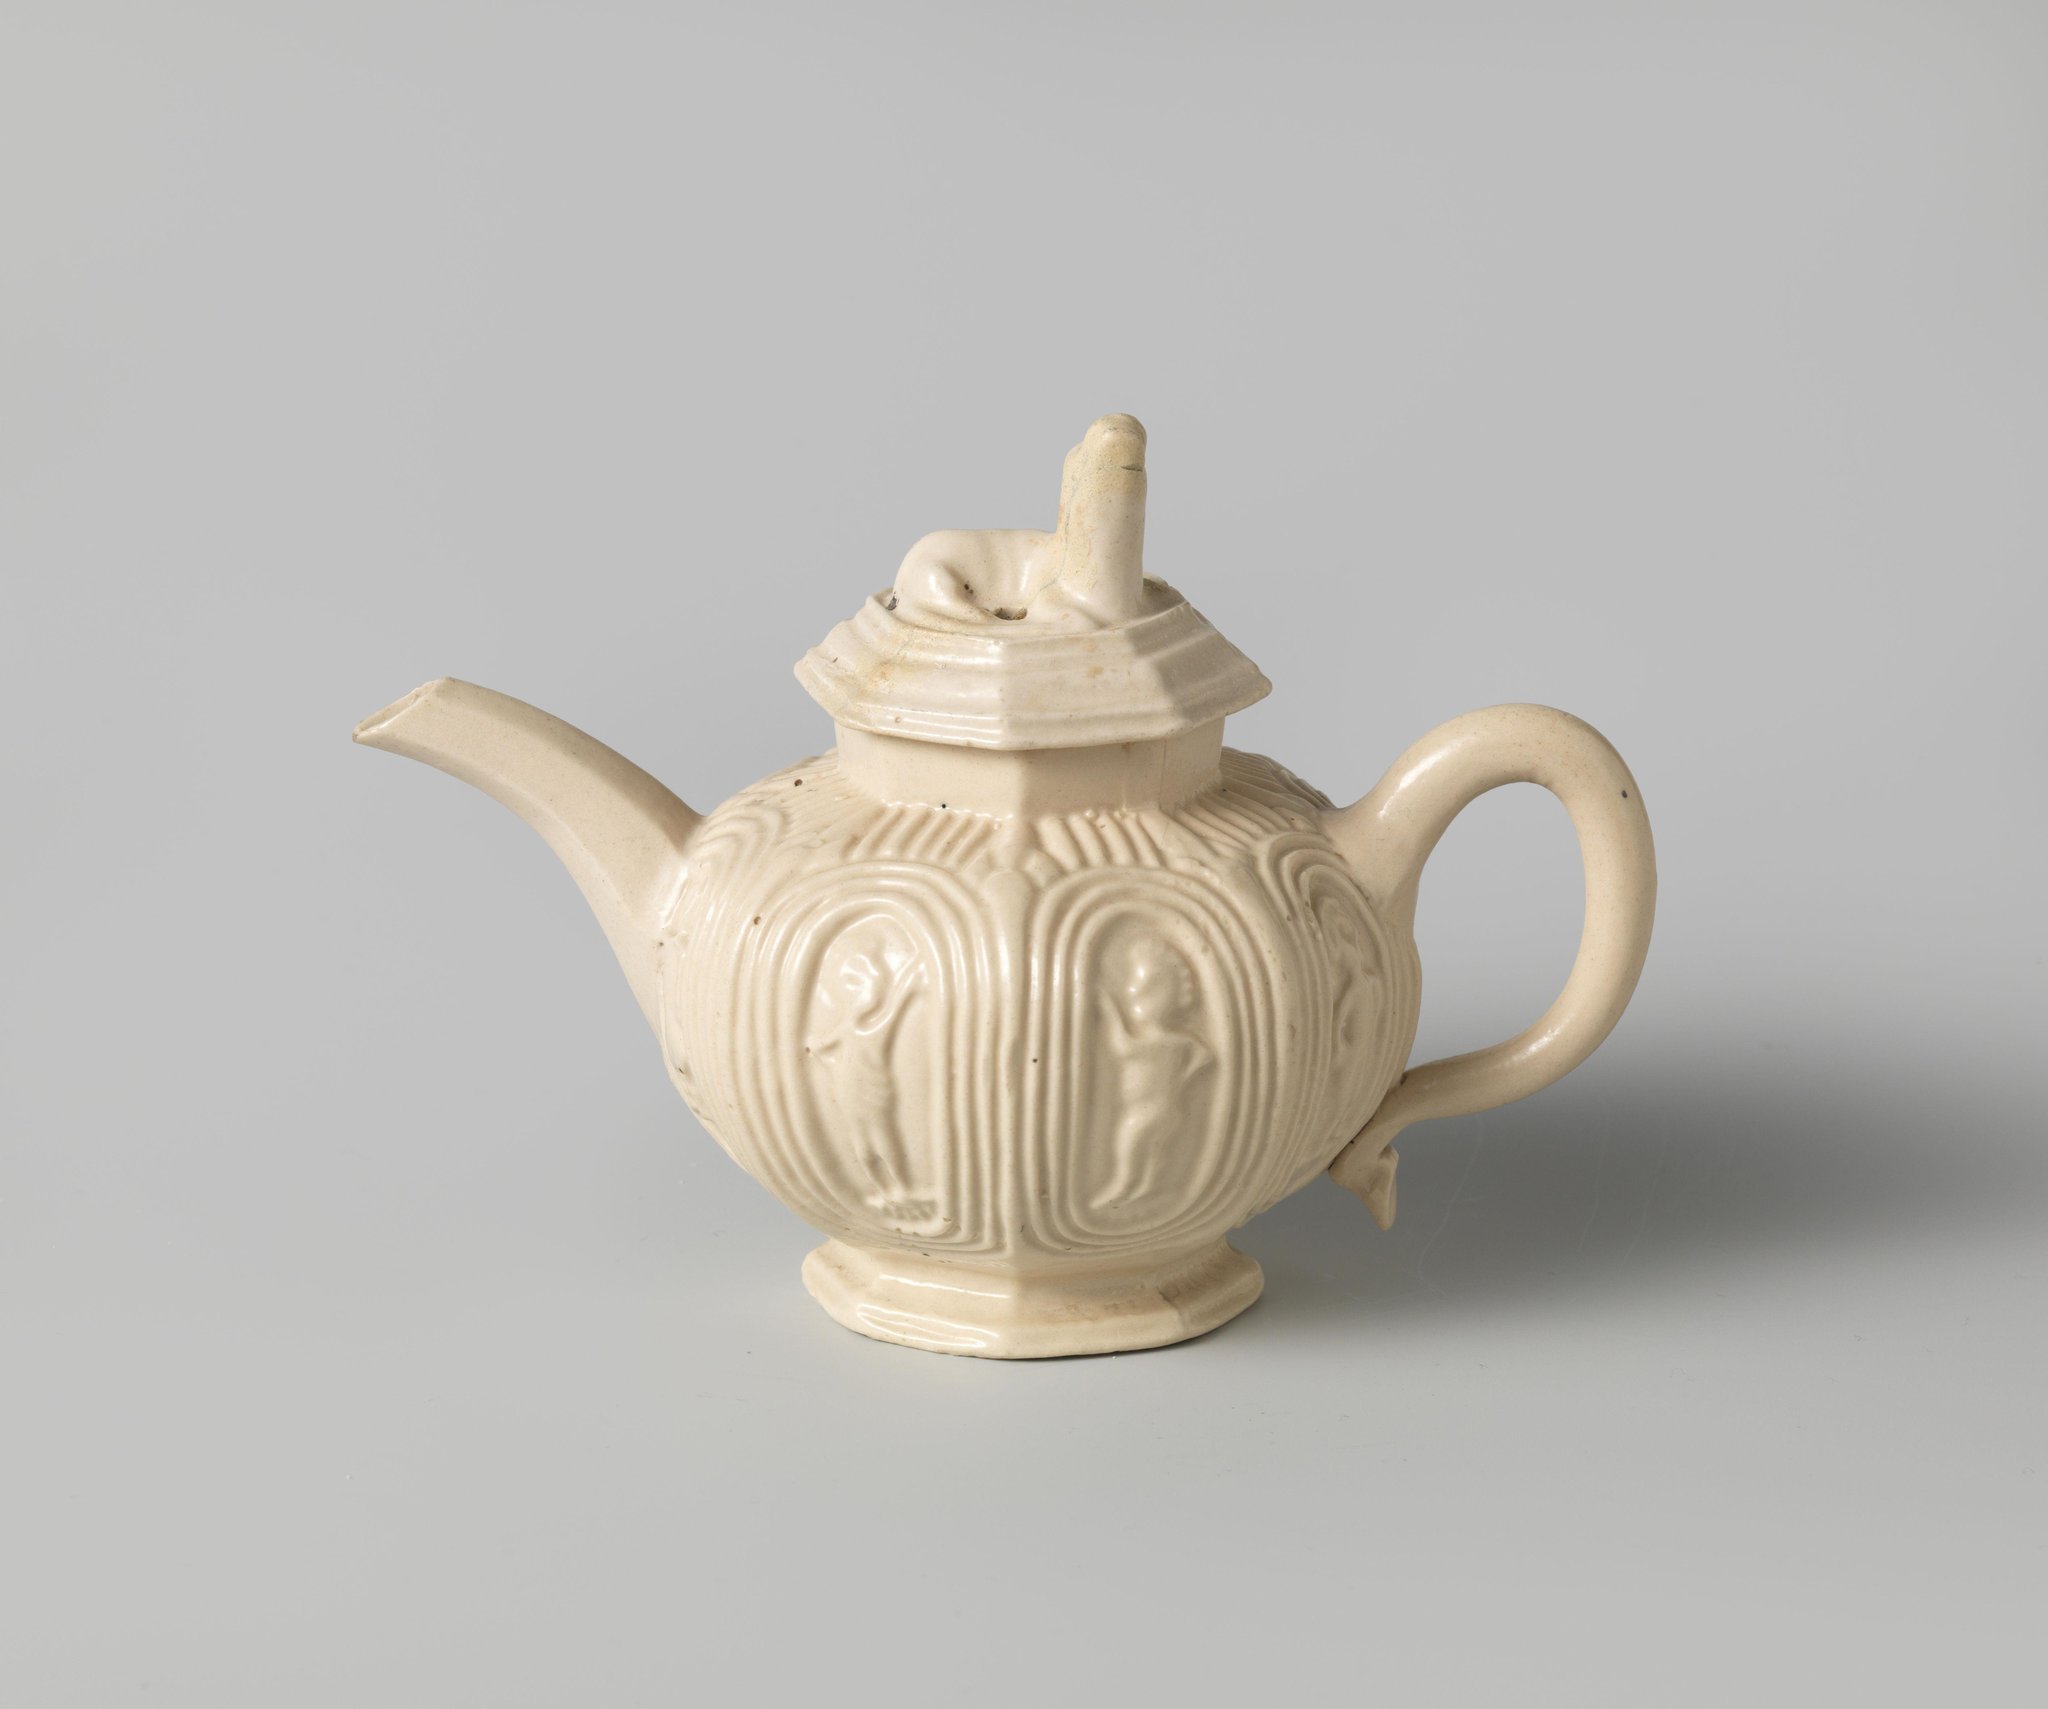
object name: pot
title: Theepot met deksel van wit steengoed met reliëffiguren; Crouch ware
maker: Anonymous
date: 1740-1760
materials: stoneware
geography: england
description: Achthoekige, bolvormige theepot van wit steengoed. De pot heeft een gebogen tuit, een C-vormig oor, een achthoekige standring en een achthoekig deksel. De pot heeft acht ovale medaillons in reliëf waarbinnen een figuur in reliëf, het deksel heeft een liggend dier (zeehond ?) als knop.